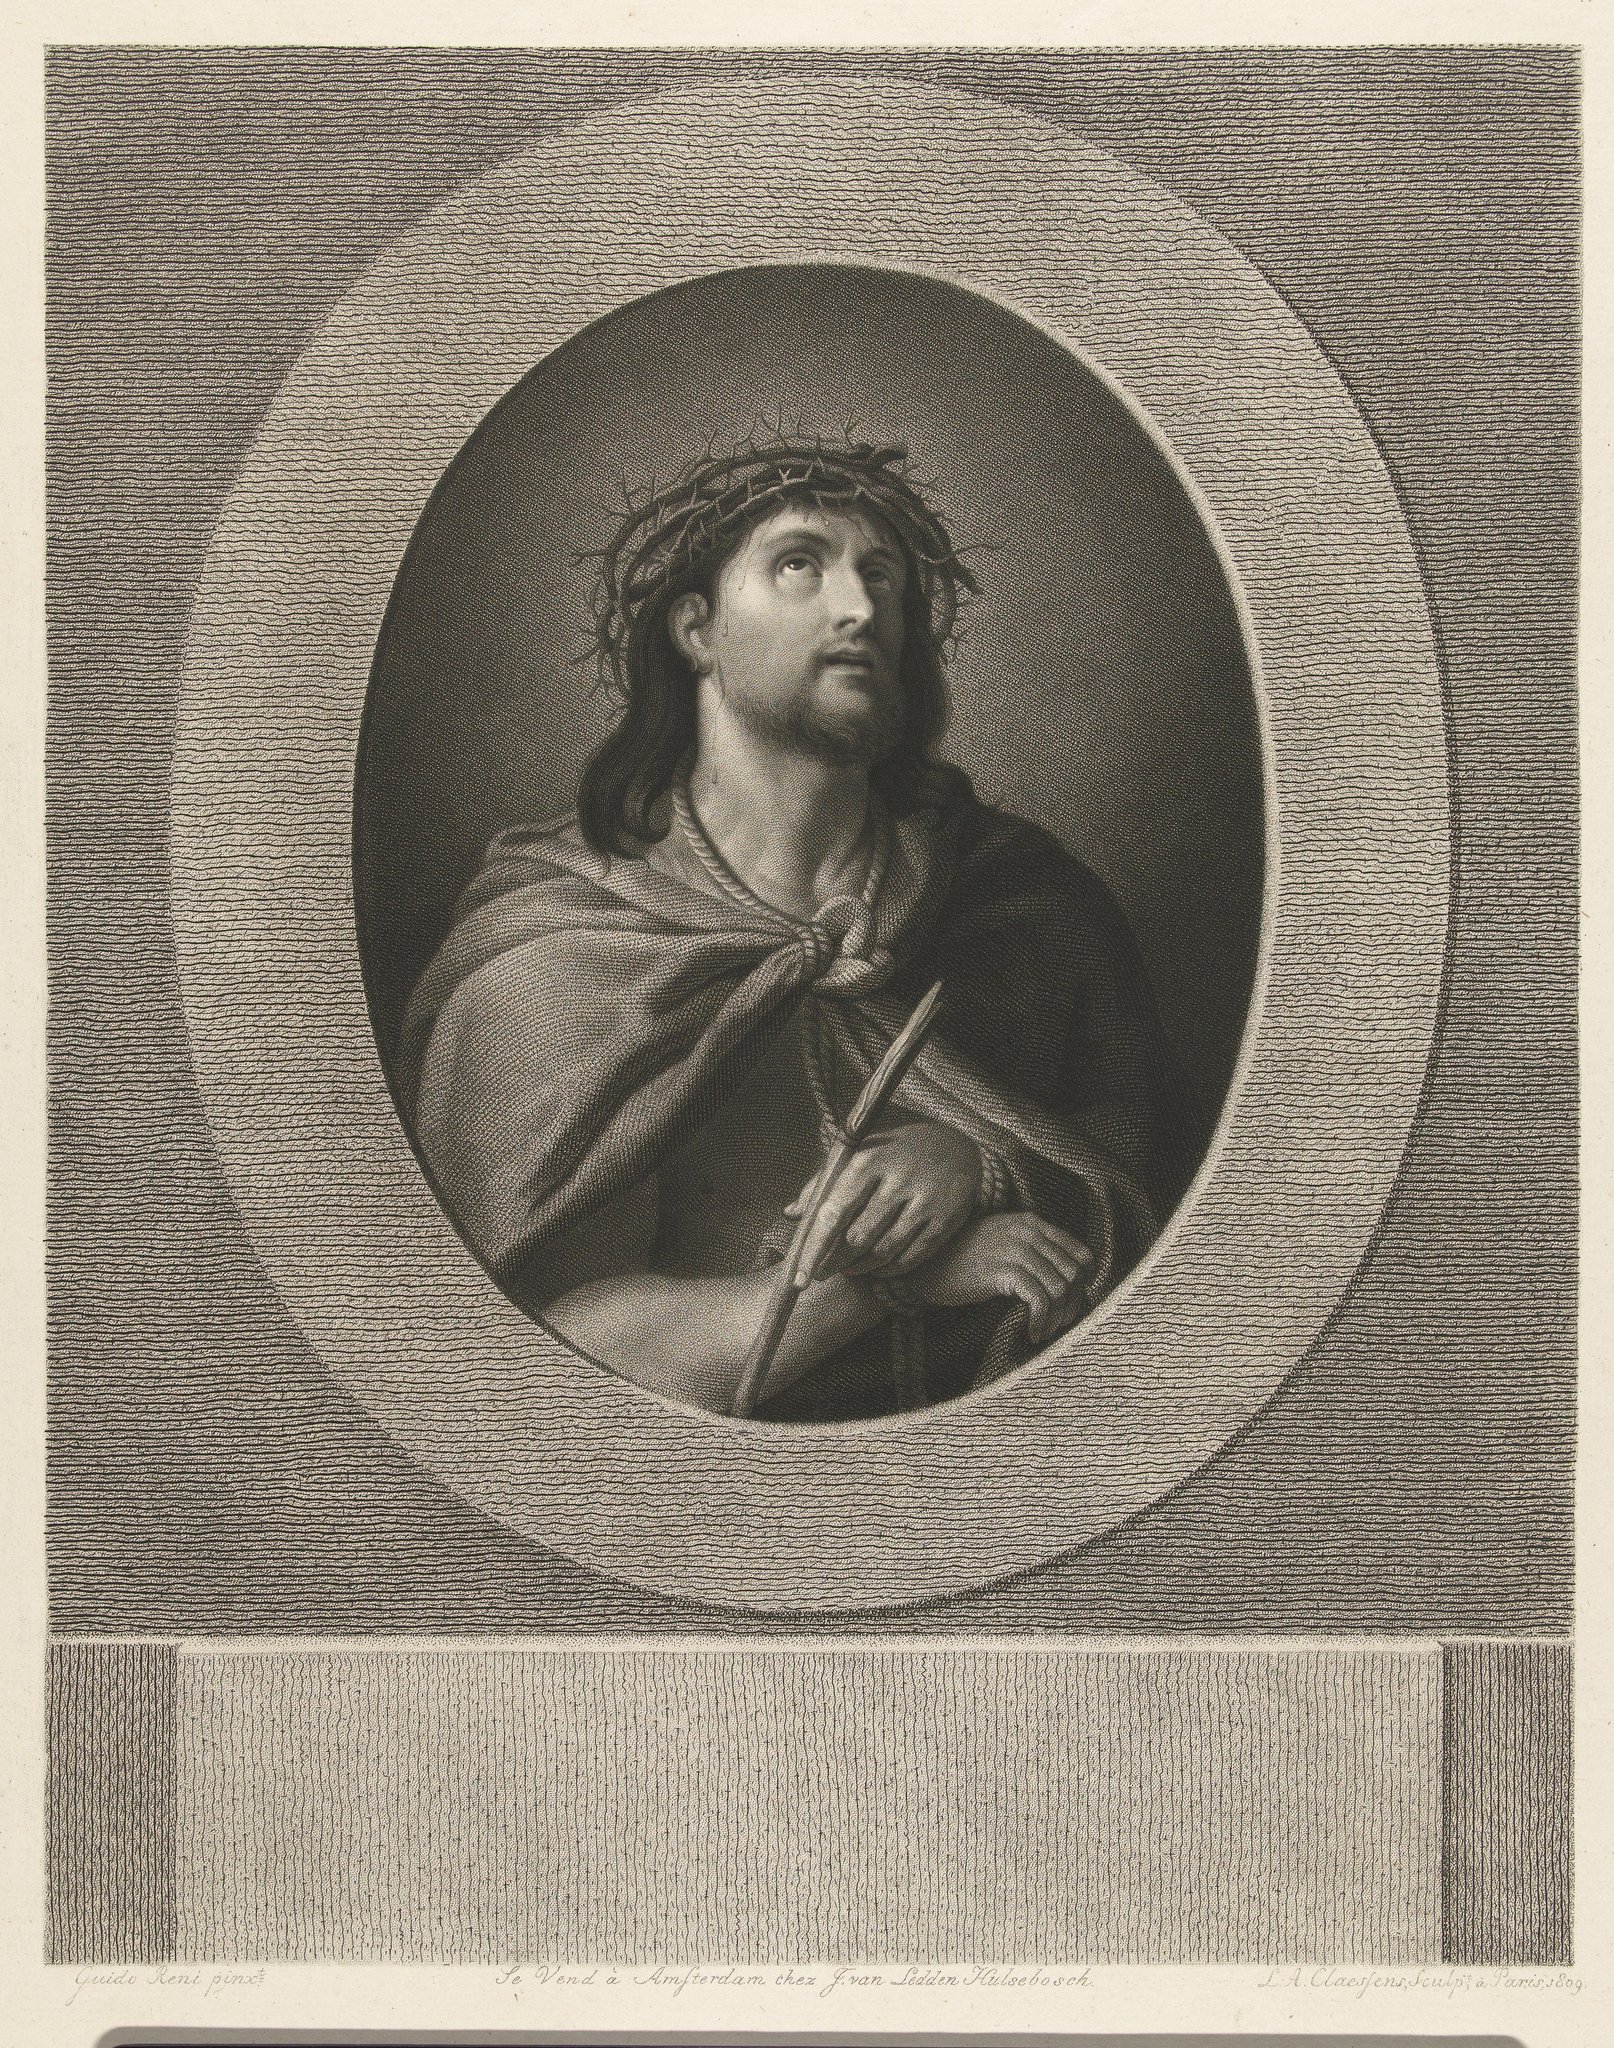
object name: print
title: Christus geboeid en met doornenkroon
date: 1809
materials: paper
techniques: engraving, etching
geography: paris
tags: christ triumphing (with crown, head usually upright)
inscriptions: collector's mark: Lugt 2228